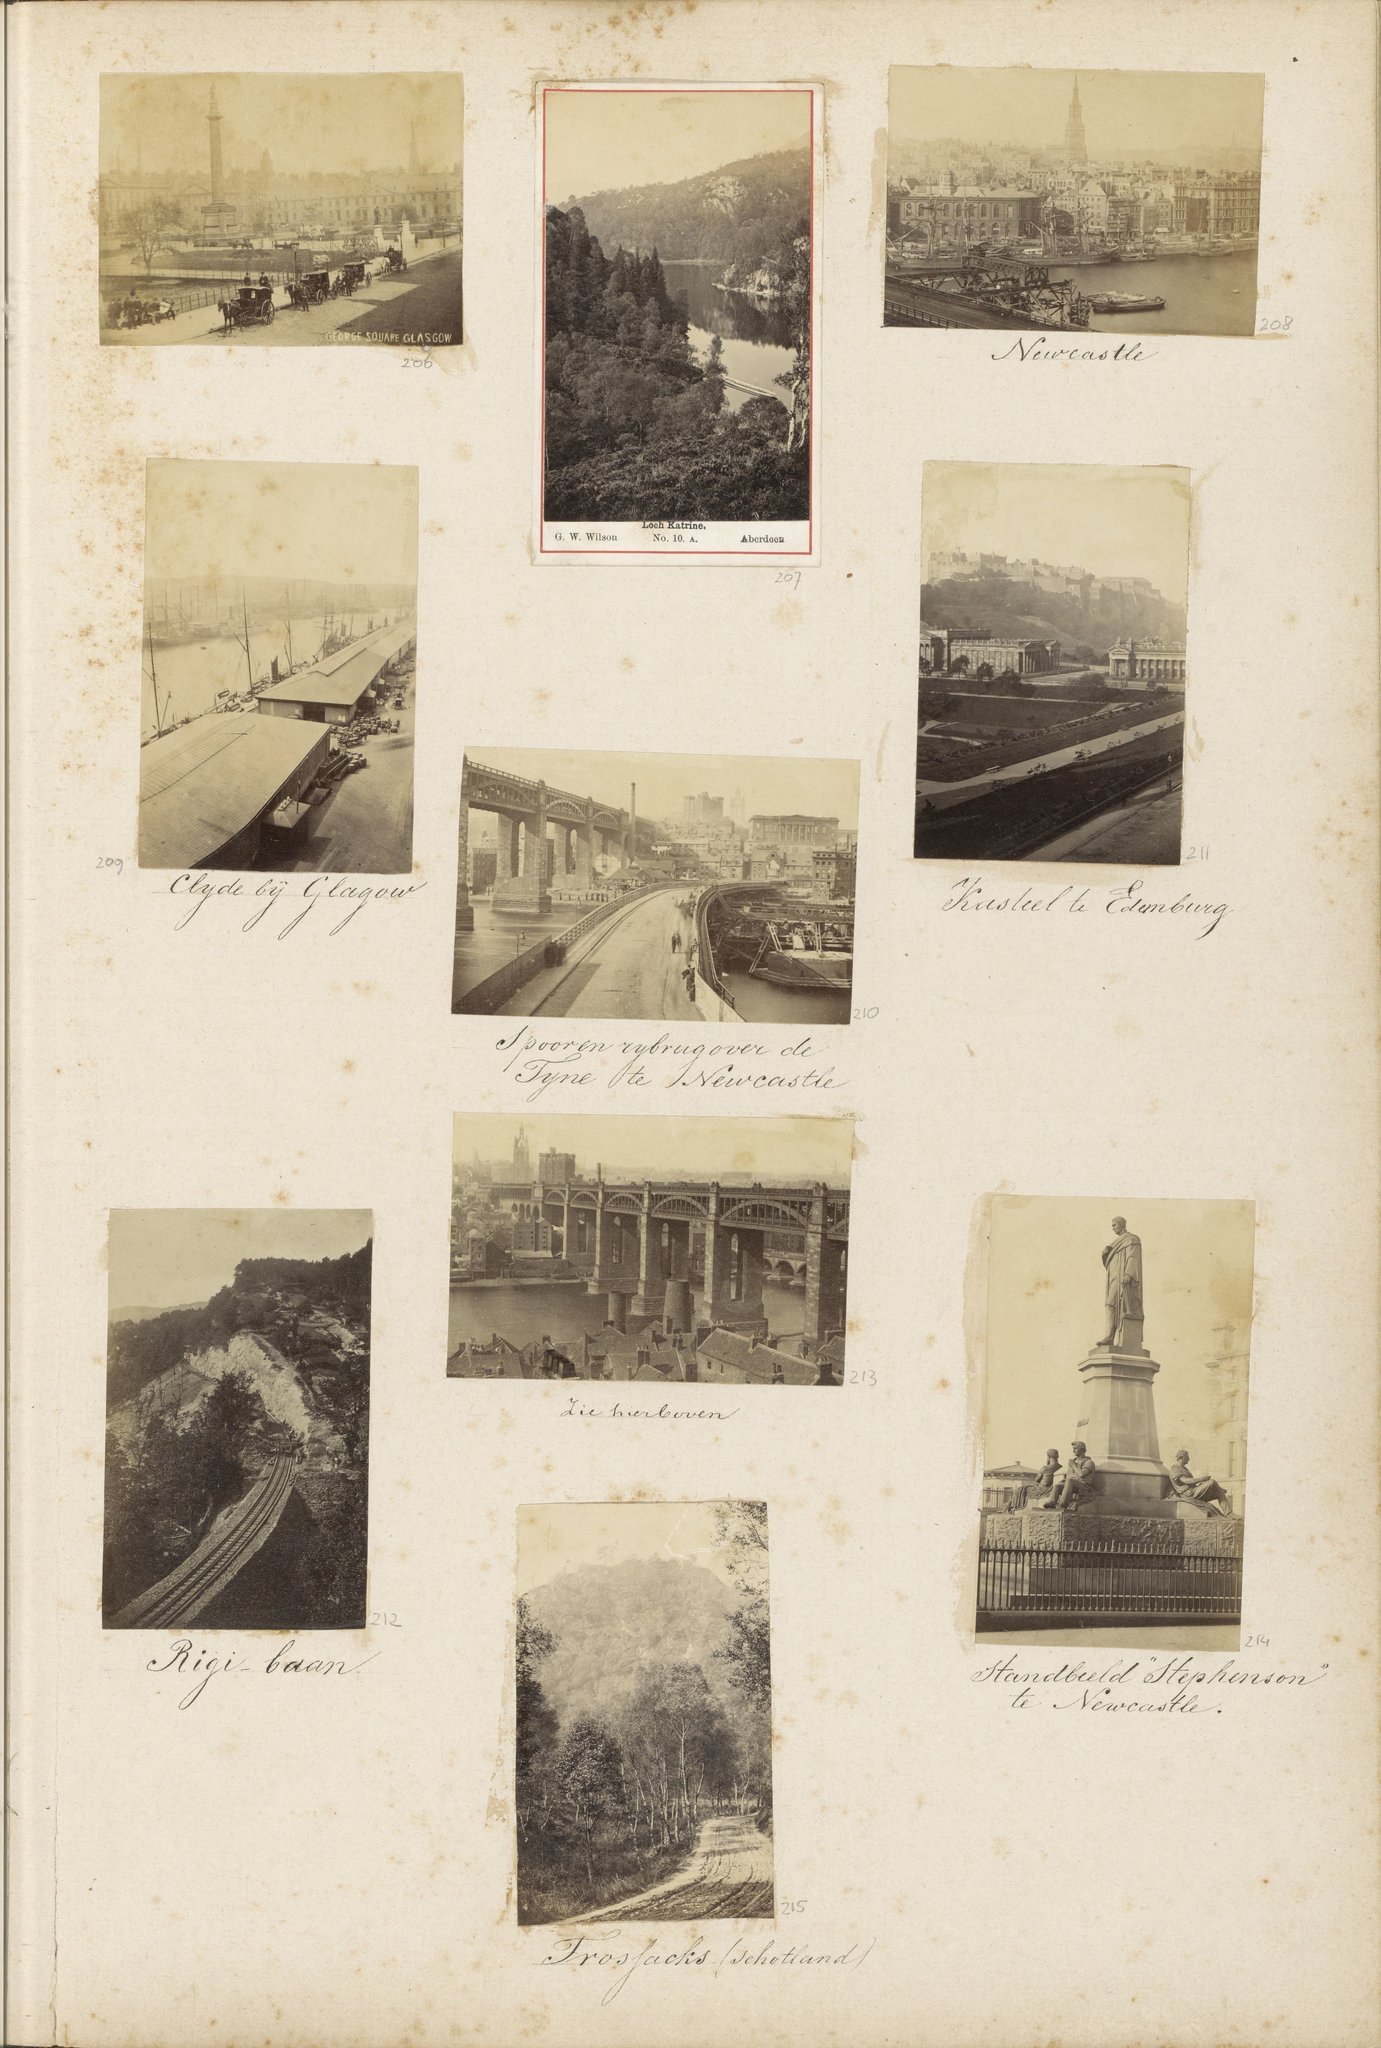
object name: album leaf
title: Weg met karrensporen door de bergen bij Trossachs in Schotland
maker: Anonymous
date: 1870-1880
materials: paper, photographic support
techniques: albumen print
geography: trossachs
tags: road, path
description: Onderdeel van Fotoalbum van Robert Daniel Crommelin (1841-1907).